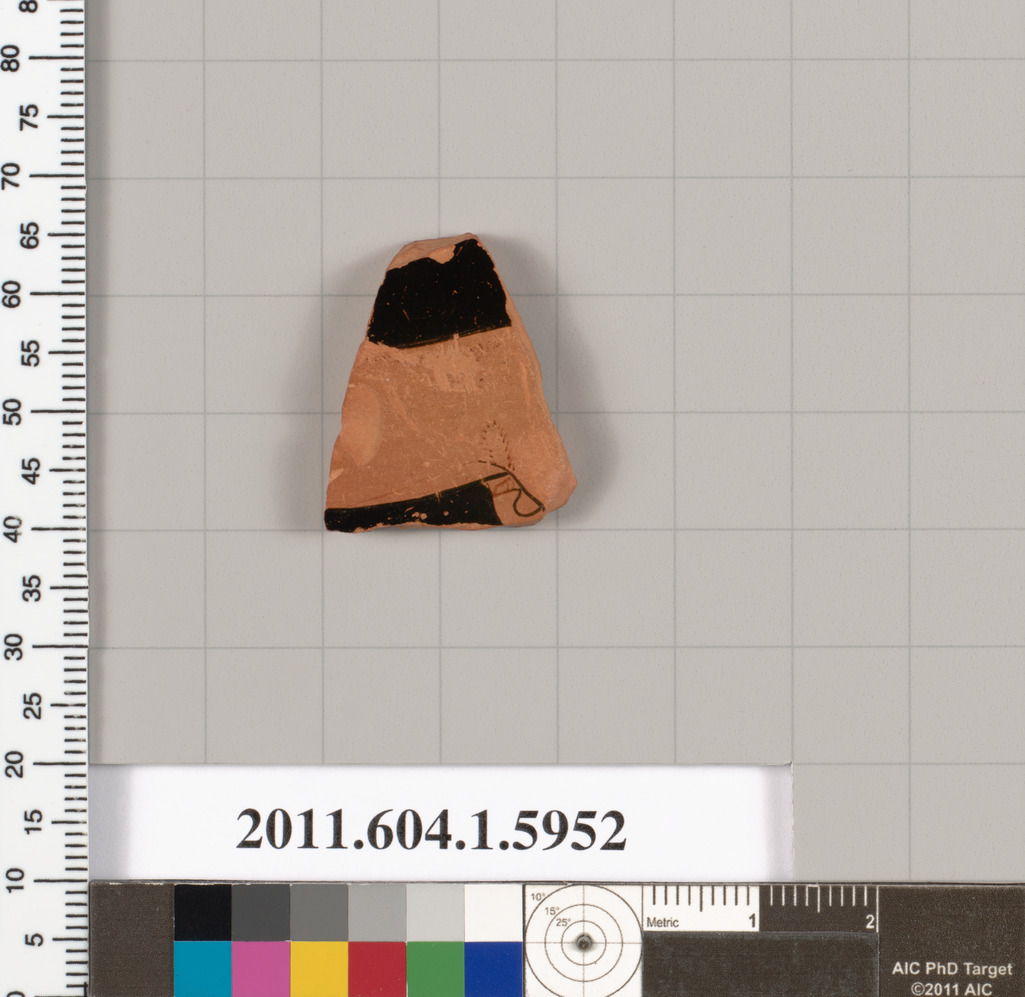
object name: kylix fragment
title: Terracotta fragment of a kylix (drinking cup)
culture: greek, attic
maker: skythes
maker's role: artist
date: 433-567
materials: terracotta